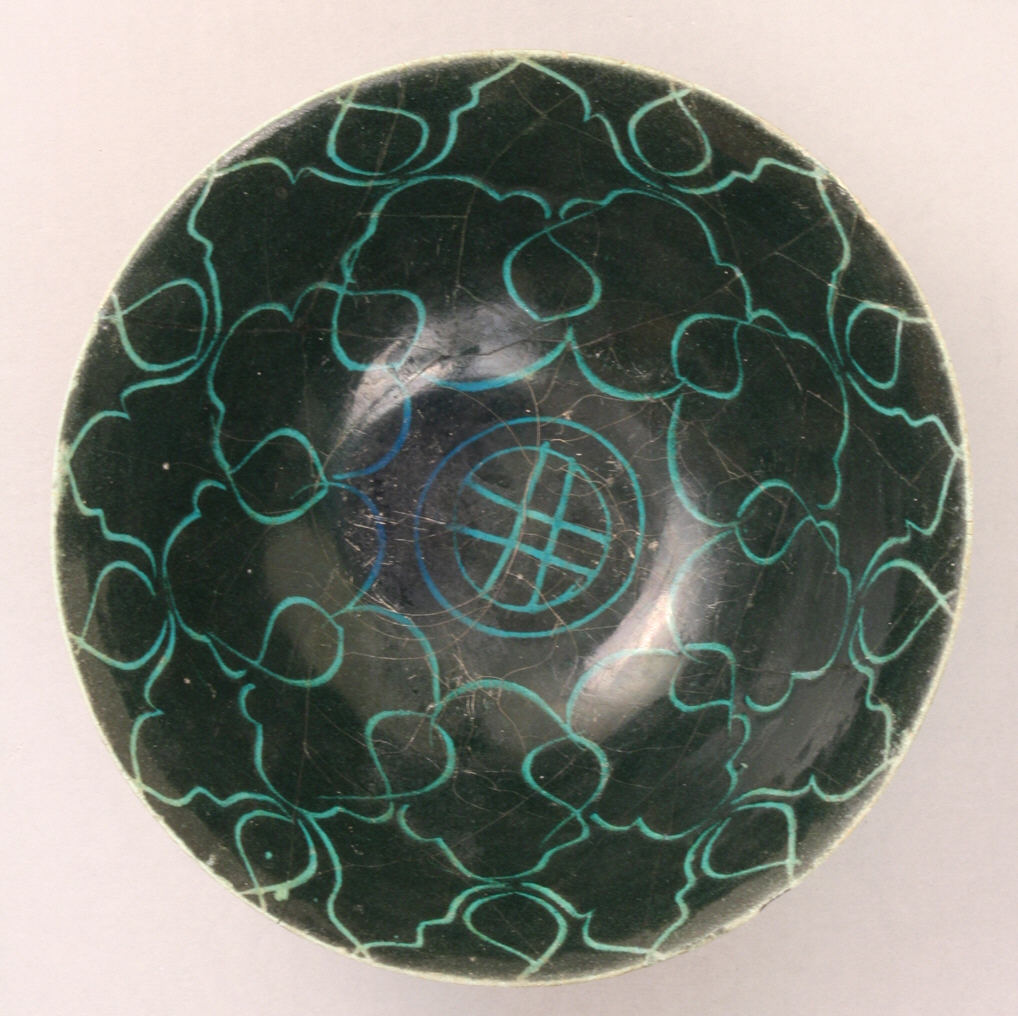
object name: bowl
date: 1201-1300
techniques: painting, underglaze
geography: iran